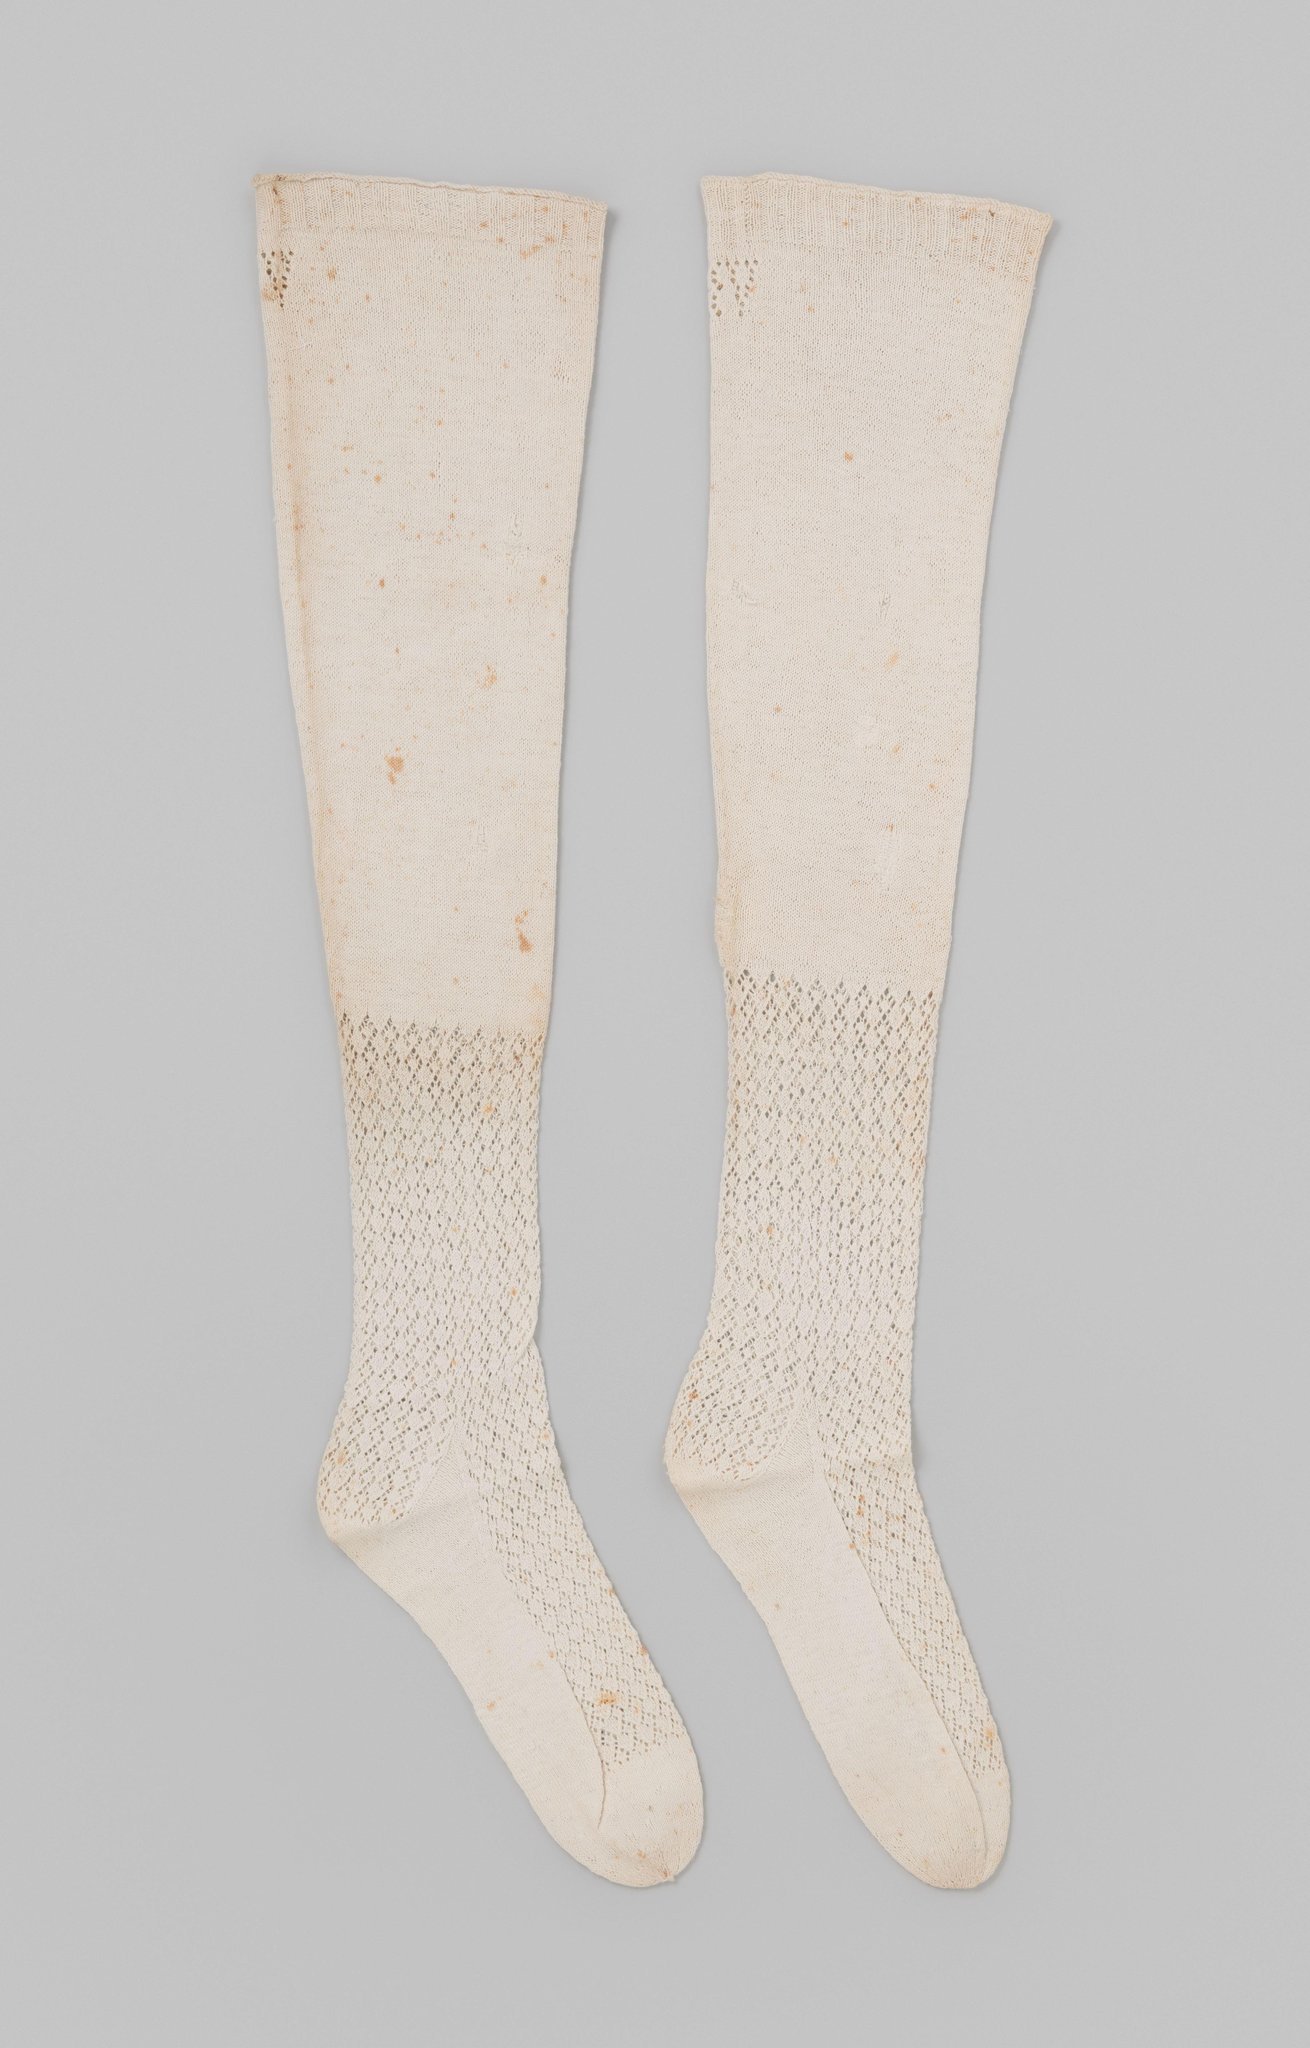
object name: stocking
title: Kous van gebreid wit katoen, waarvan de klink in ajour en het kuit deel effen, met bovenaan een smalle boord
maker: Anonymous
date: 1900-1910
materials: cotton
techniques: embroidery, knitting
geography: surabaya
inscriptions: inscription: ‘'IV'’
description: Kous van gebreid wit katoen, waarvan de klink in ajour in een klein ruittpatroon en het kuit deel effen, met bovenaan een smalle boord. Bovenaan aan de achterzijde 'IV'.